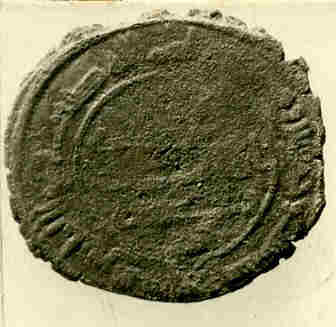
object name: coin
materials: copper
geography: iran